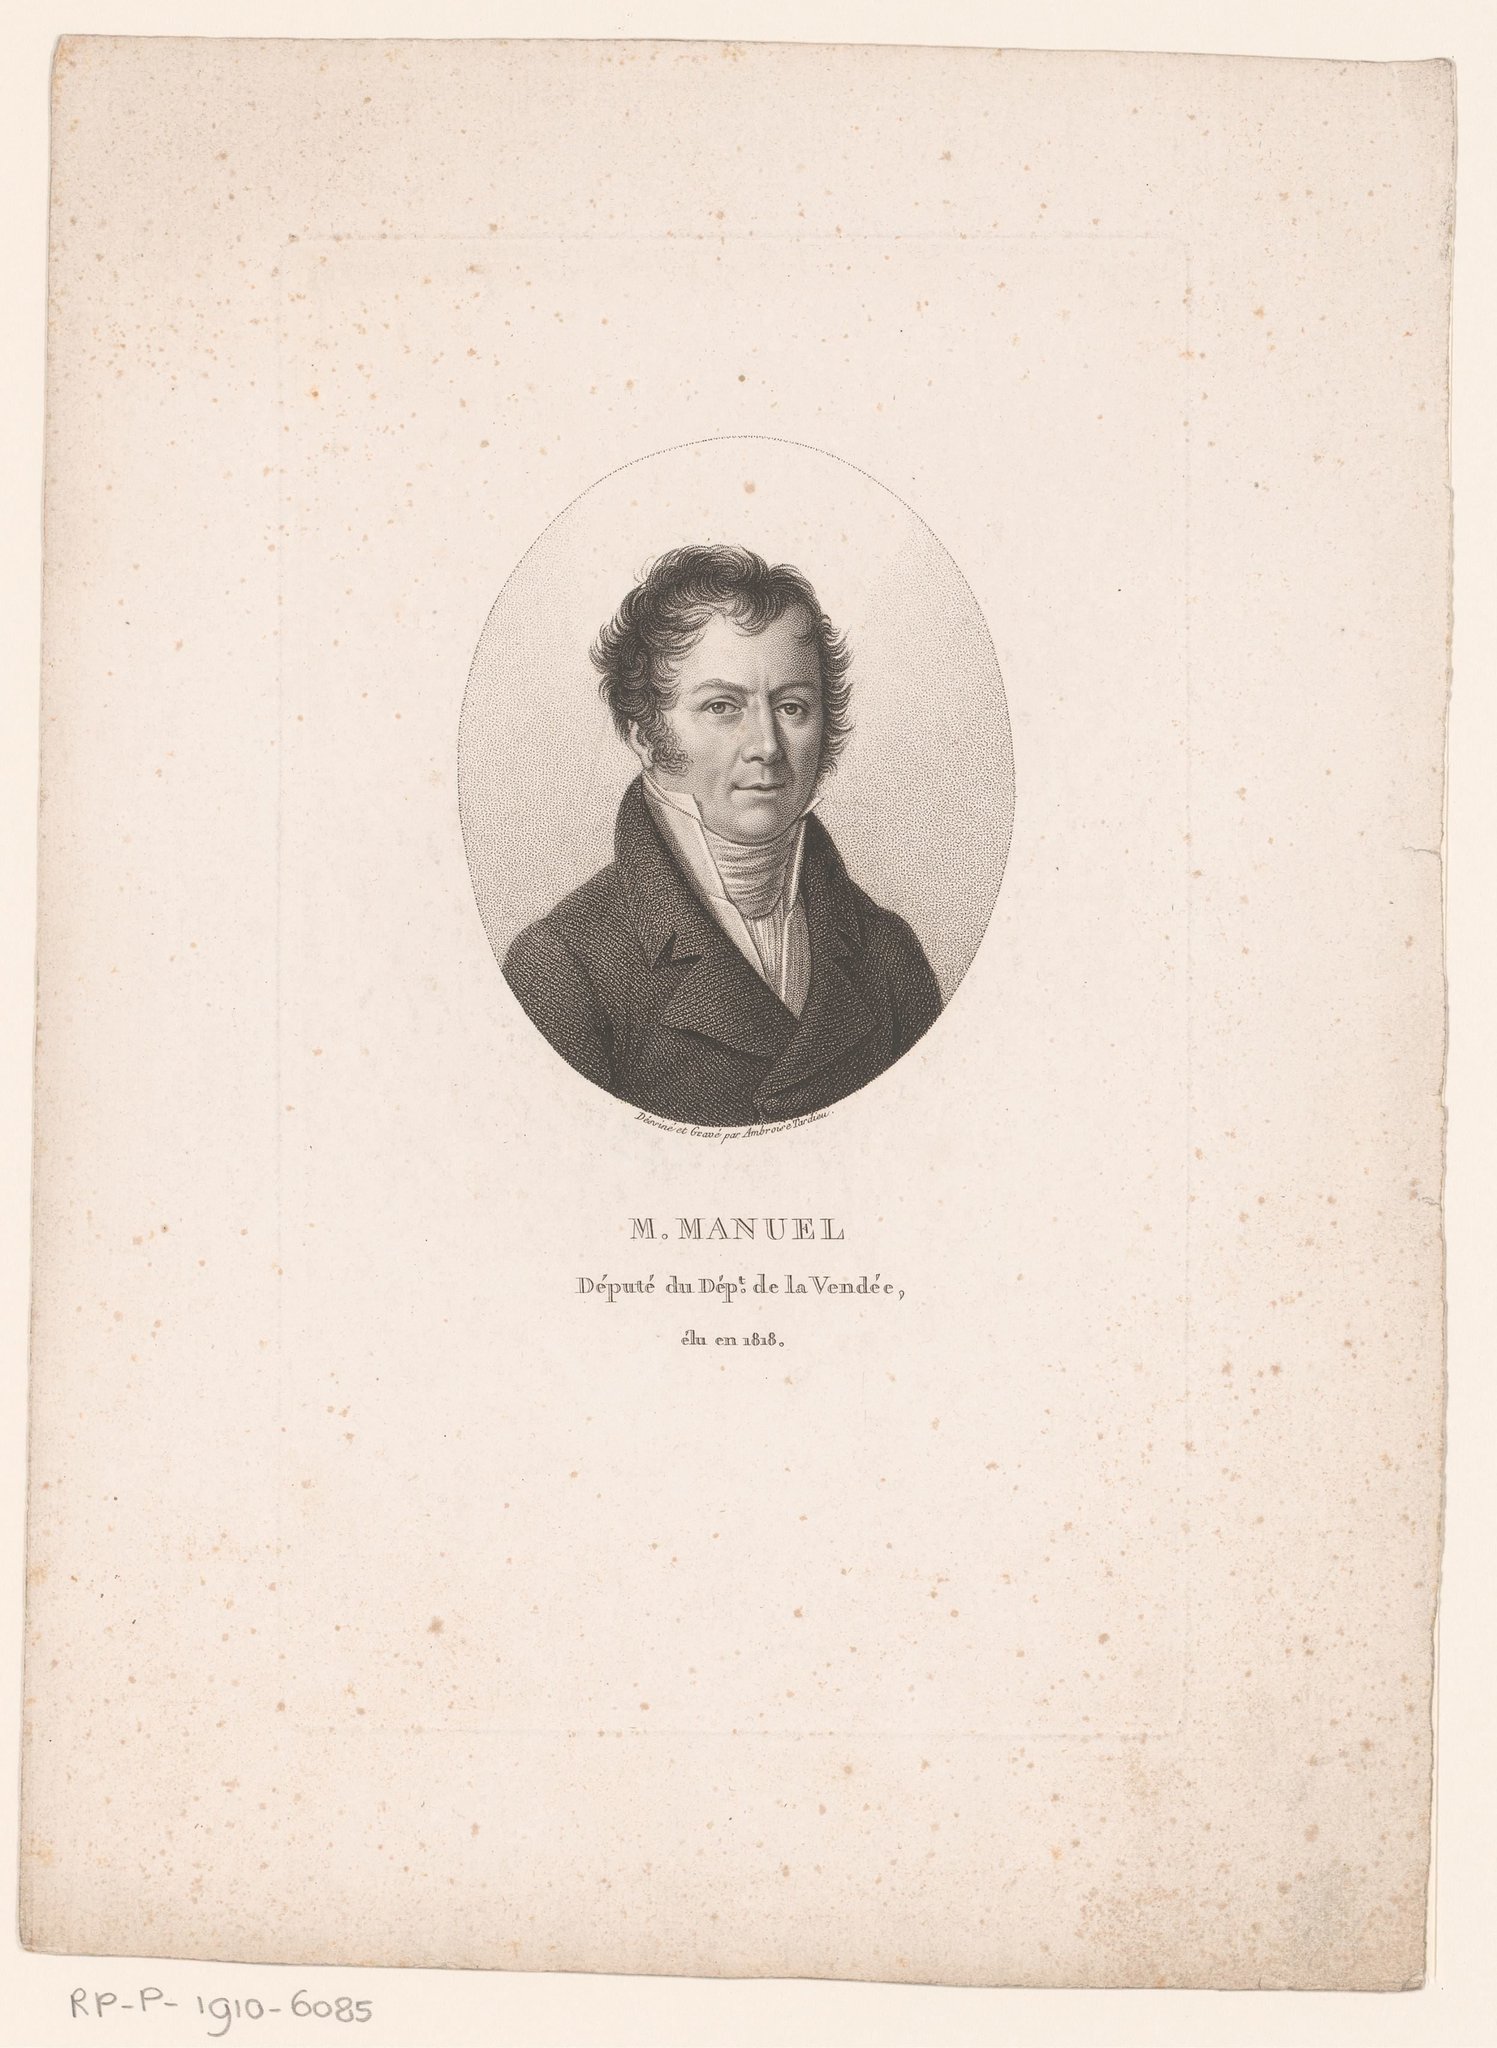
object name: book illustration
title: Portret van Jacques-Antoine Manuel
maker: ambroise tardieu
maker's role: print maker, printer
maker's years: 1788-1841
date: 1820-1821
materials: paper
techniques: engraving, roulette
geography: paris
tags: historical persons, politician, e.g. party leader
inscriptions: collector's mark: Lugt 2228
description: Prent uit: Tardieu, Ambroise. Portraits des députés, écrivains et pairs constitutionnels, défenseurs invariables de la charte et de la loi des élections du 5 février 1817. Parijs: Tardieu, Ambroise, 1820-1821.